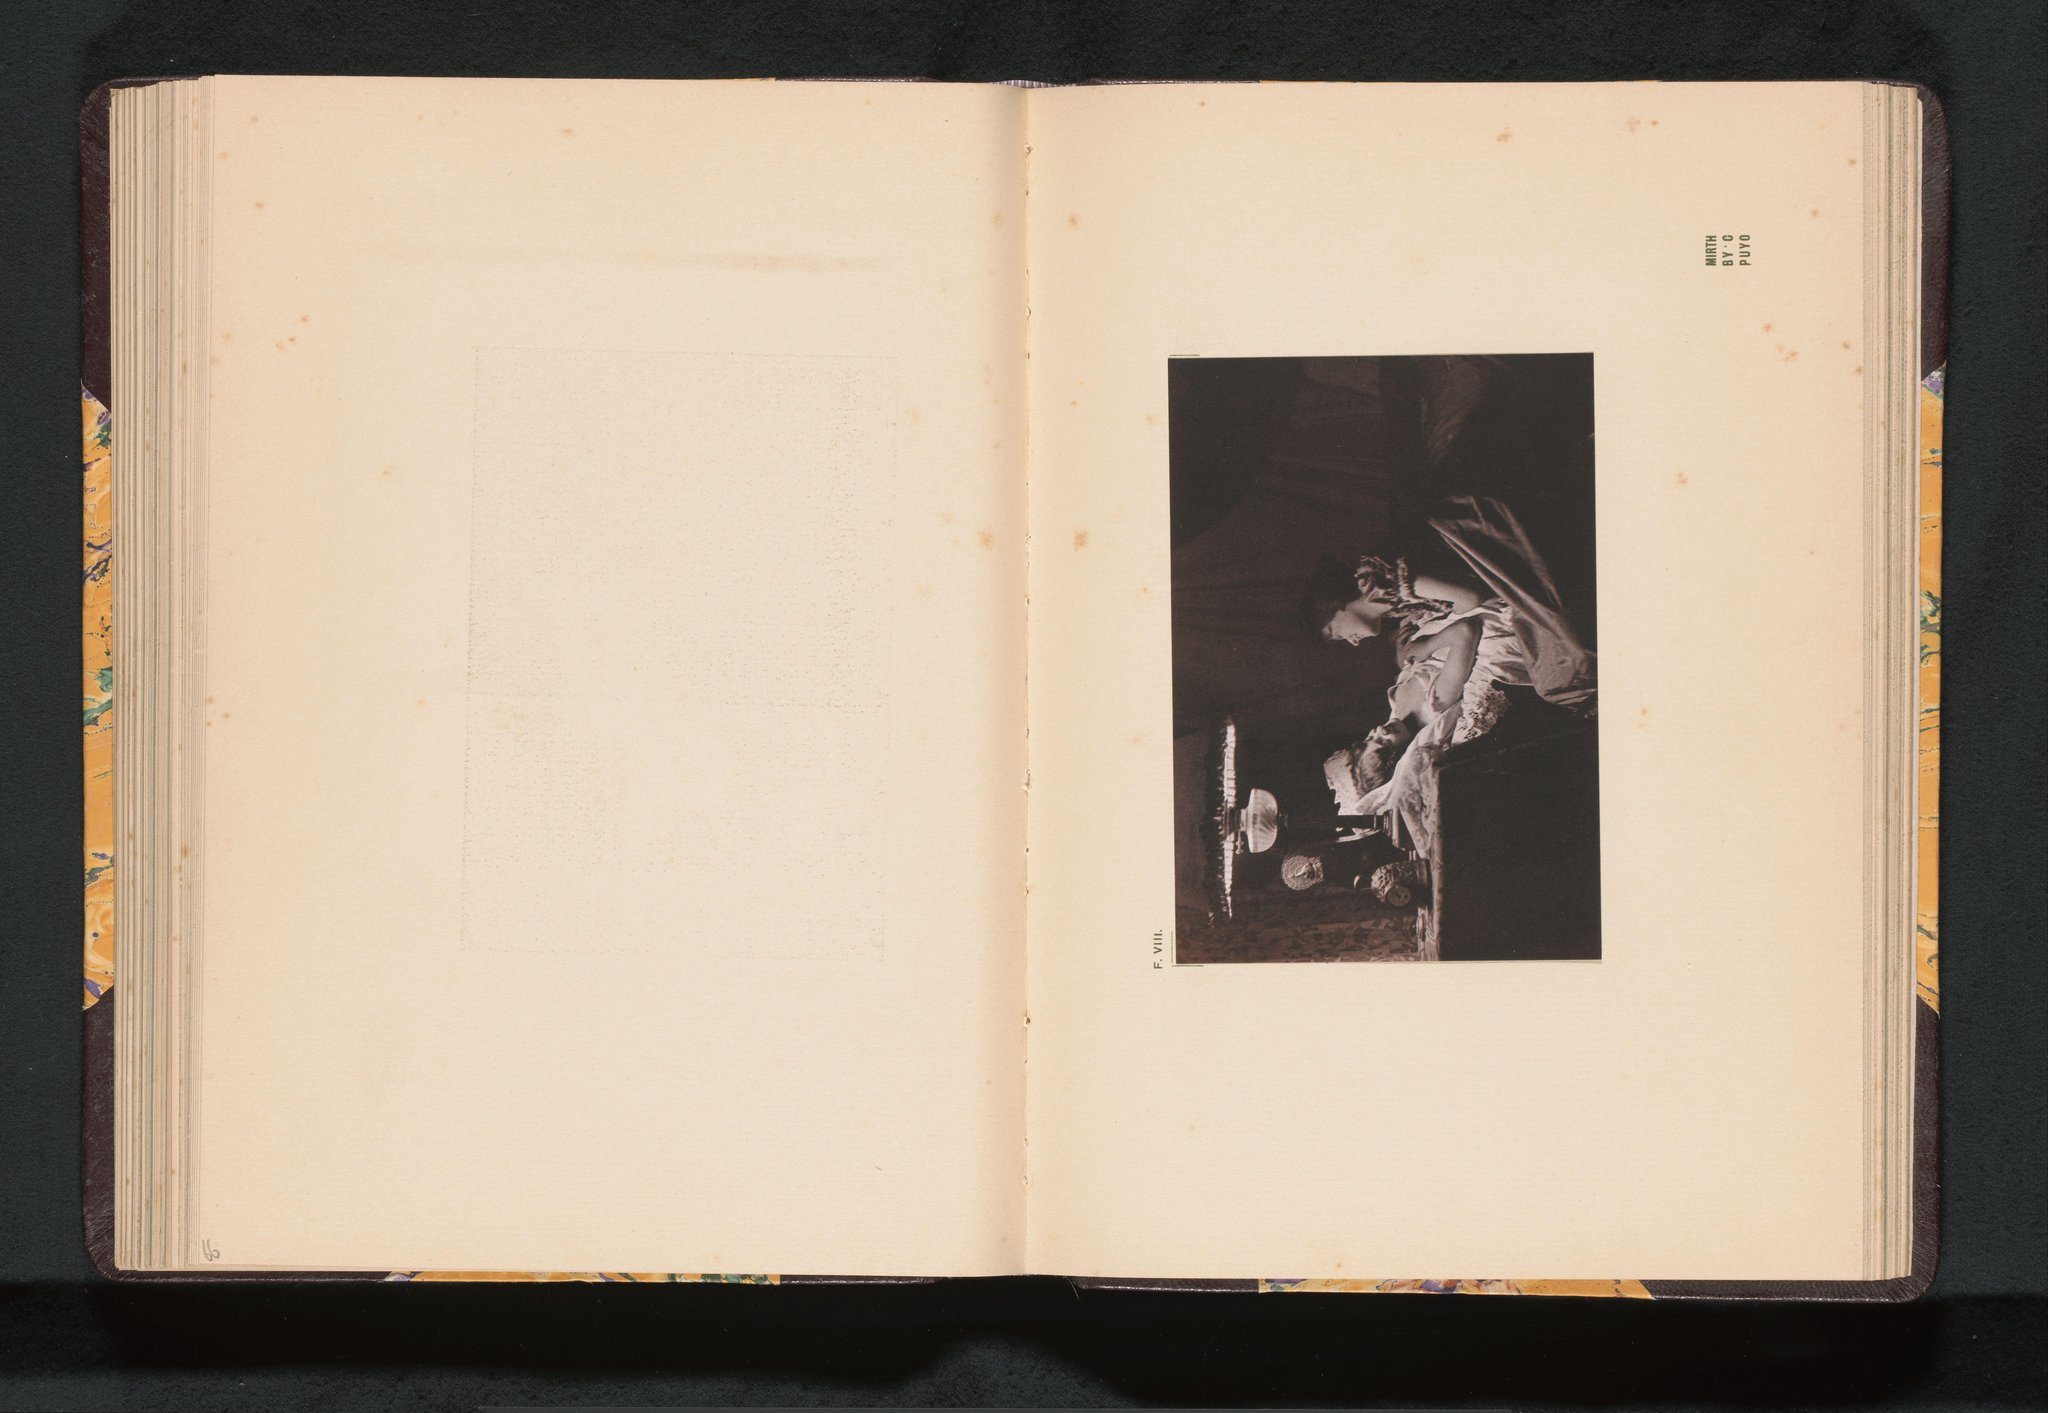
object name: page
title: Twee lachende vrouwen in de slaapkamer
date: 1900-1905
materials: paper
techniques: two-color autotype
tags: adolescent, young woman, maiden, laughing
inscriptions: inscription: ‘Mirth by C. Puyo’, inscription: ‘F. VIII.’